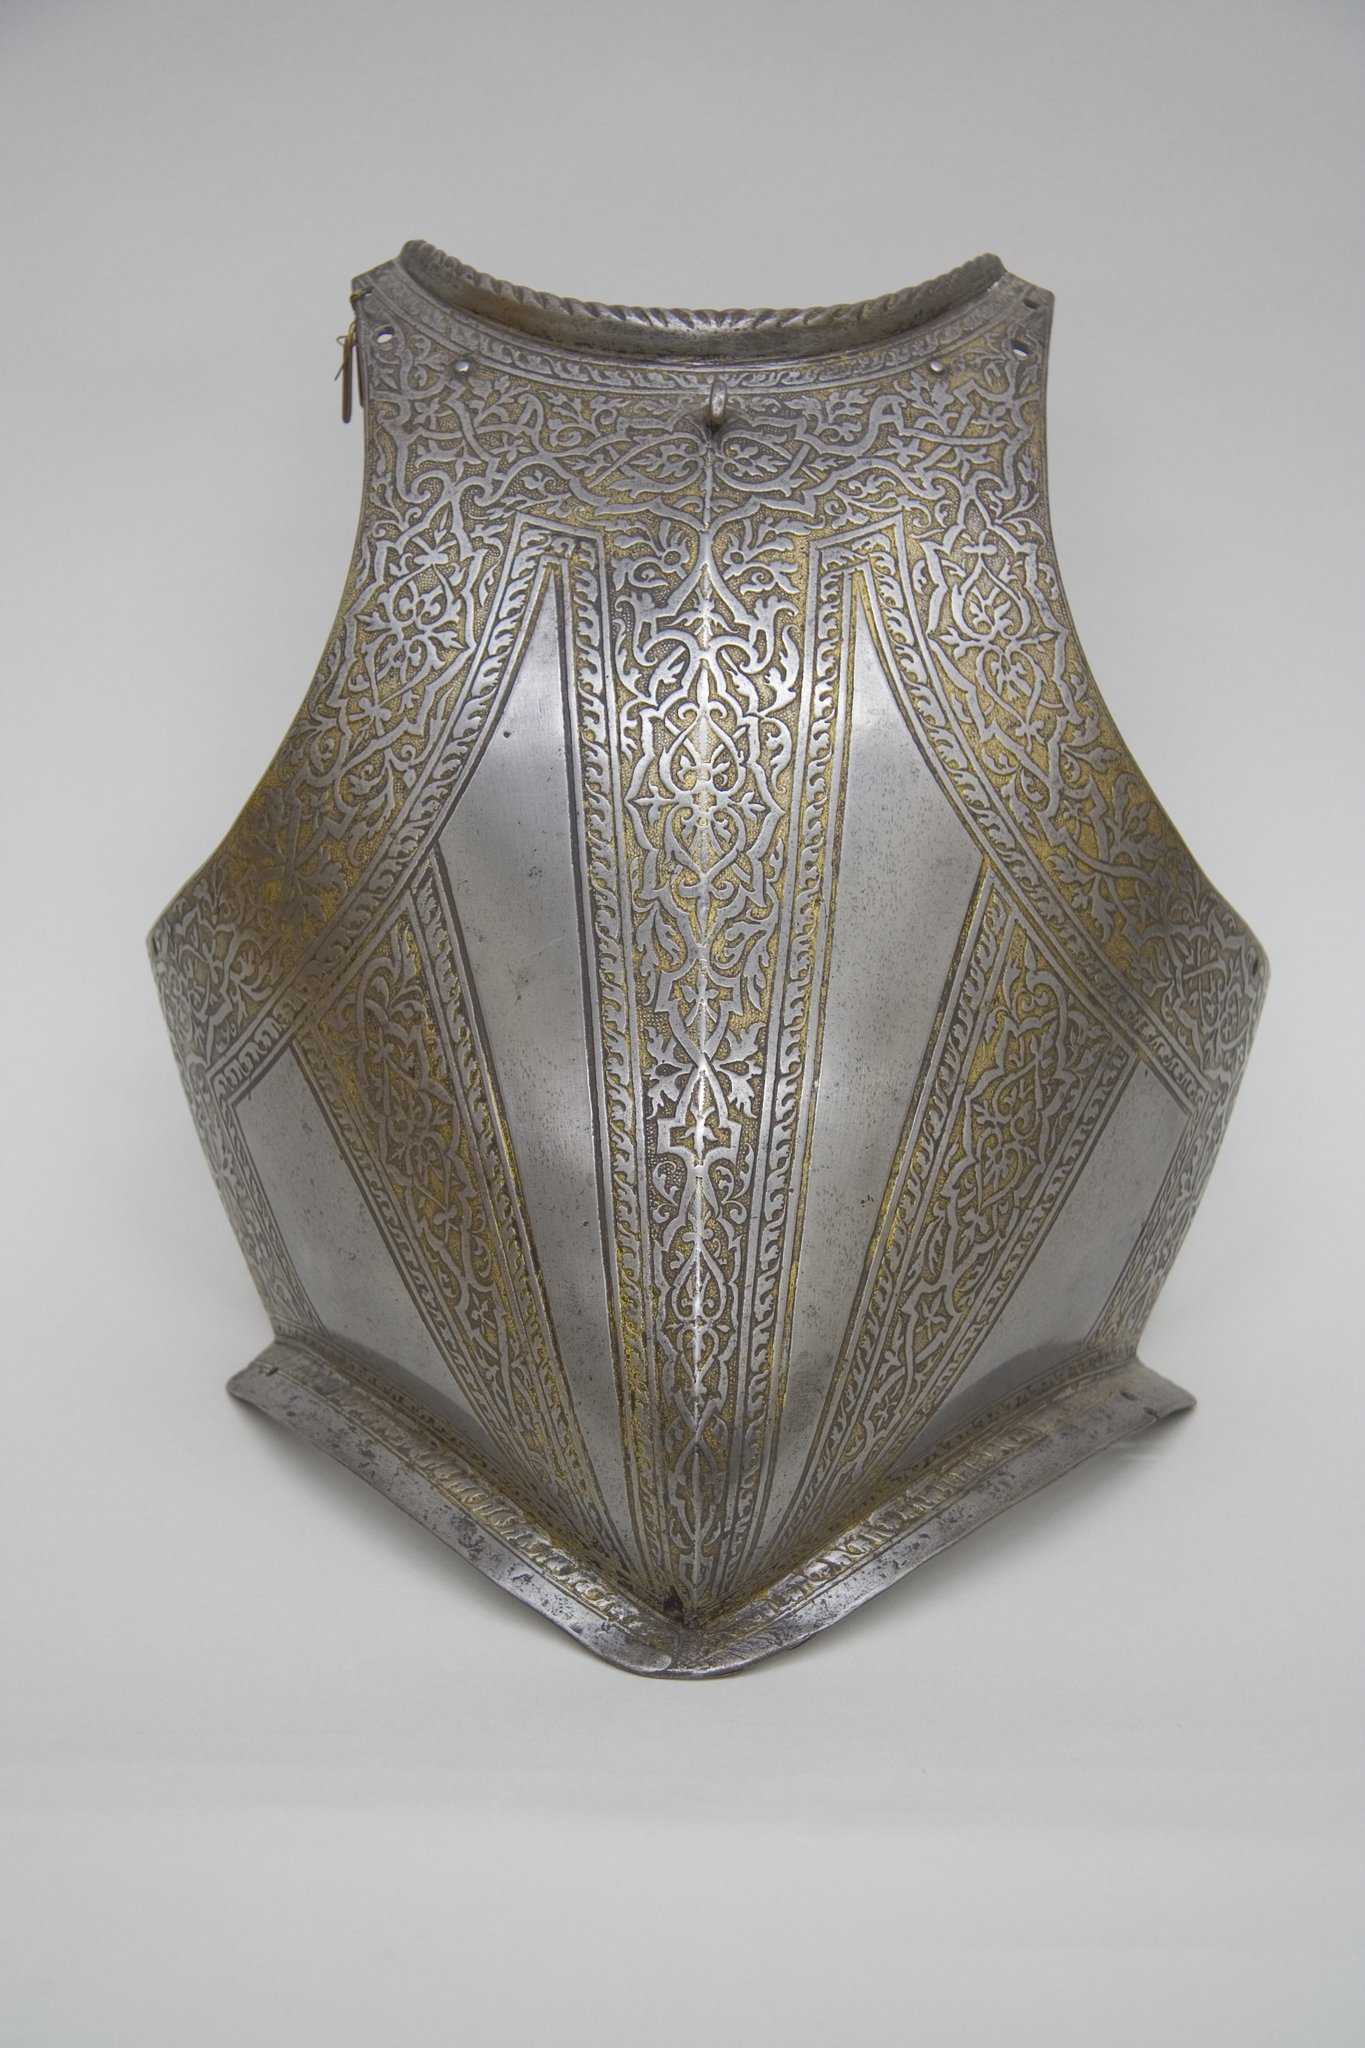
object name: breastplate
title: Breastplate from an Armor of Francesco Maria II della Rovere (1548–1631), Duke of Urbino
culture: italian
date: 1570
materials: gold, steel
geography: italy